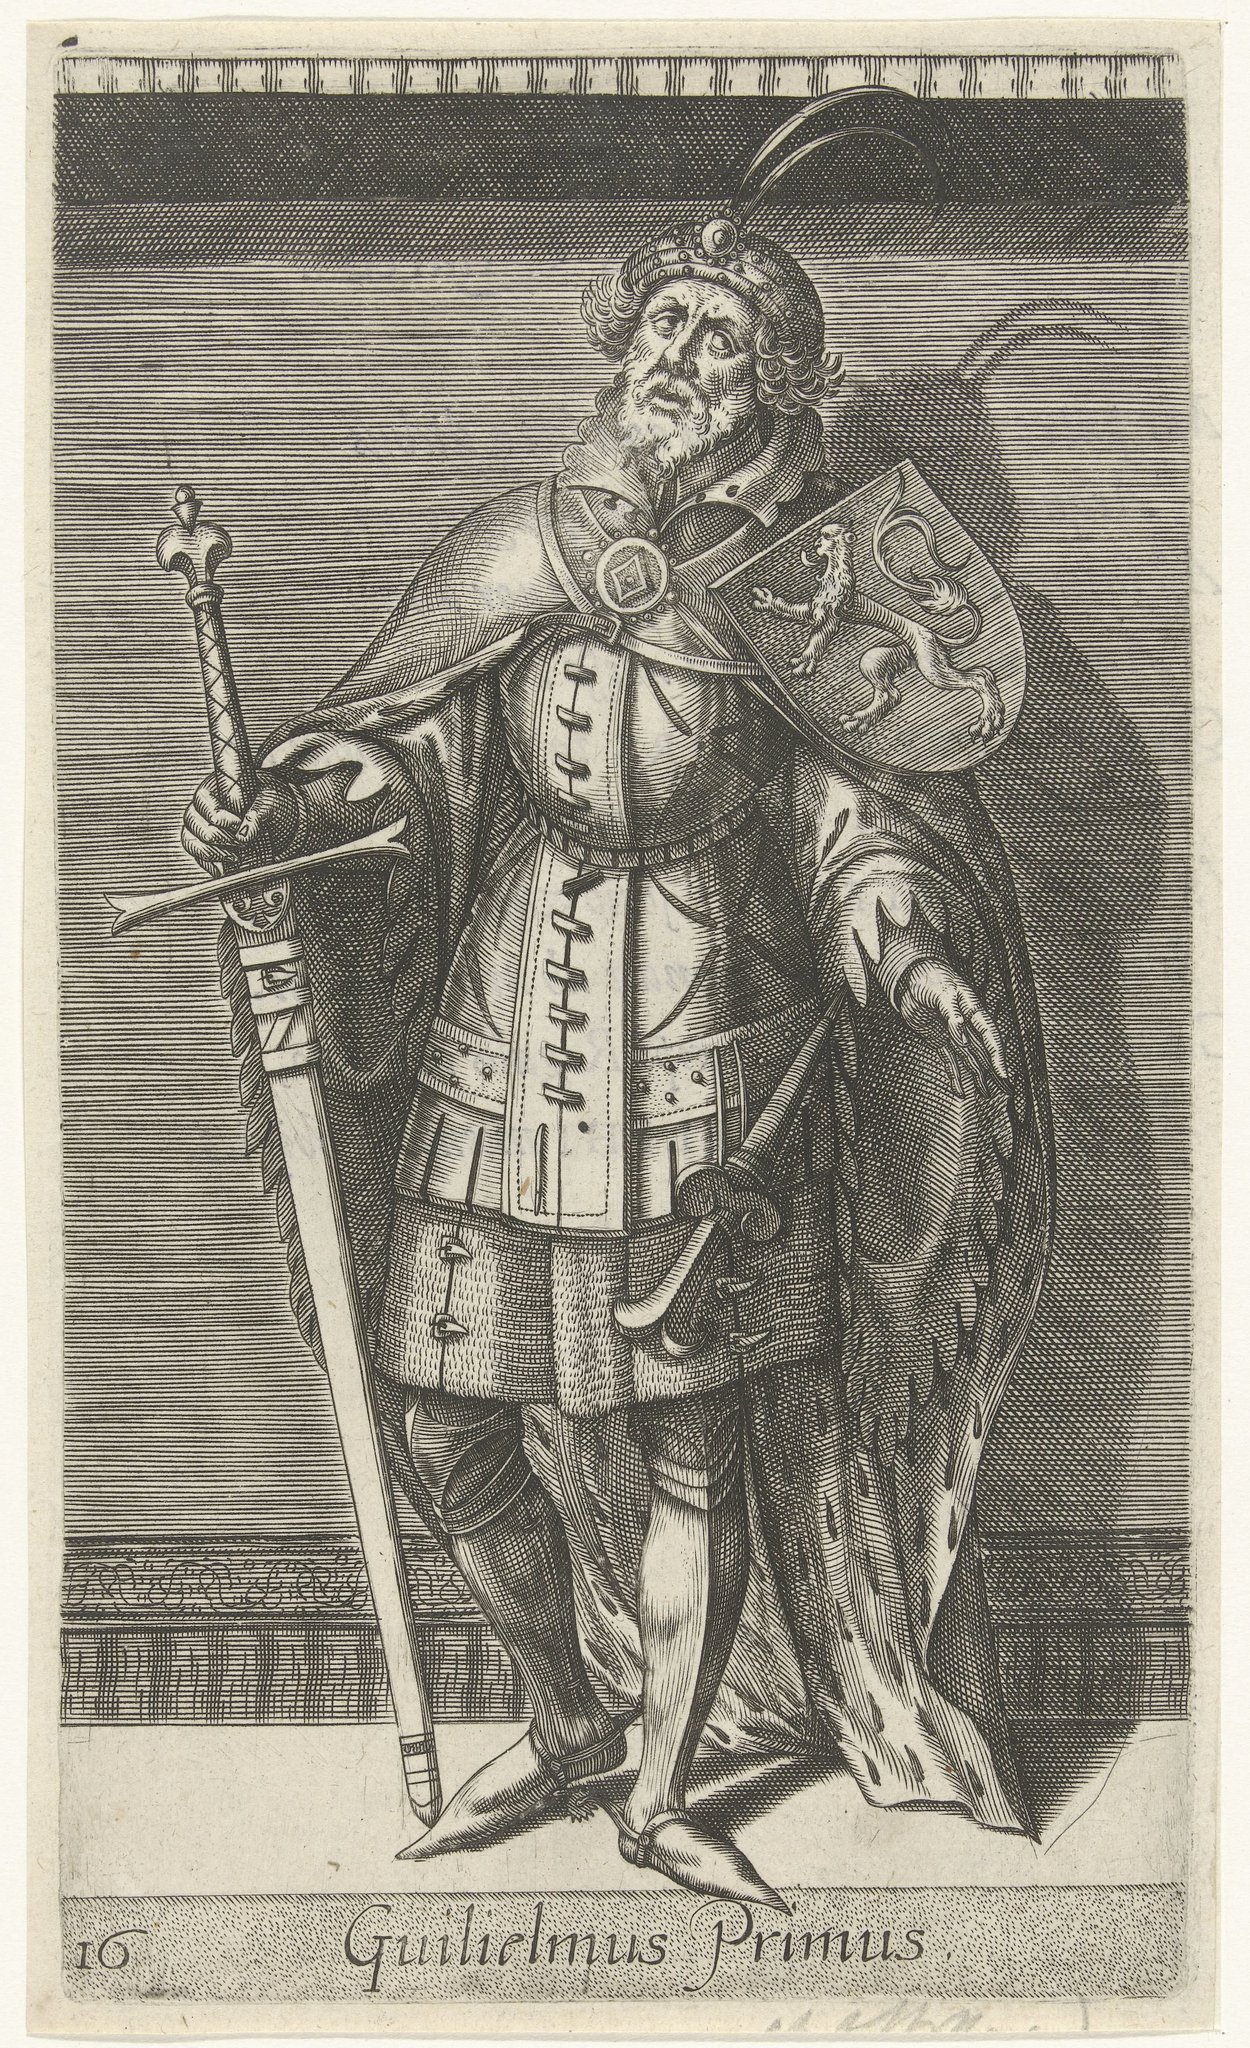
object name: book illustration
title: Portret van Willem I, graaf van Holland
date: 1578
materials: paper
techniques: engraving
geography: antwerp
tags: willem i (graaf van holland)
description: Willem I, graaf van Holland. Staande, ten voeten uit. Hij draagt een zwaard in zijn rechterhand. Op zijn linkerschouder het wapenschild van Holland. De prent dient als een illustratie bij een boek over de geschiedenis van de graven van Holland.